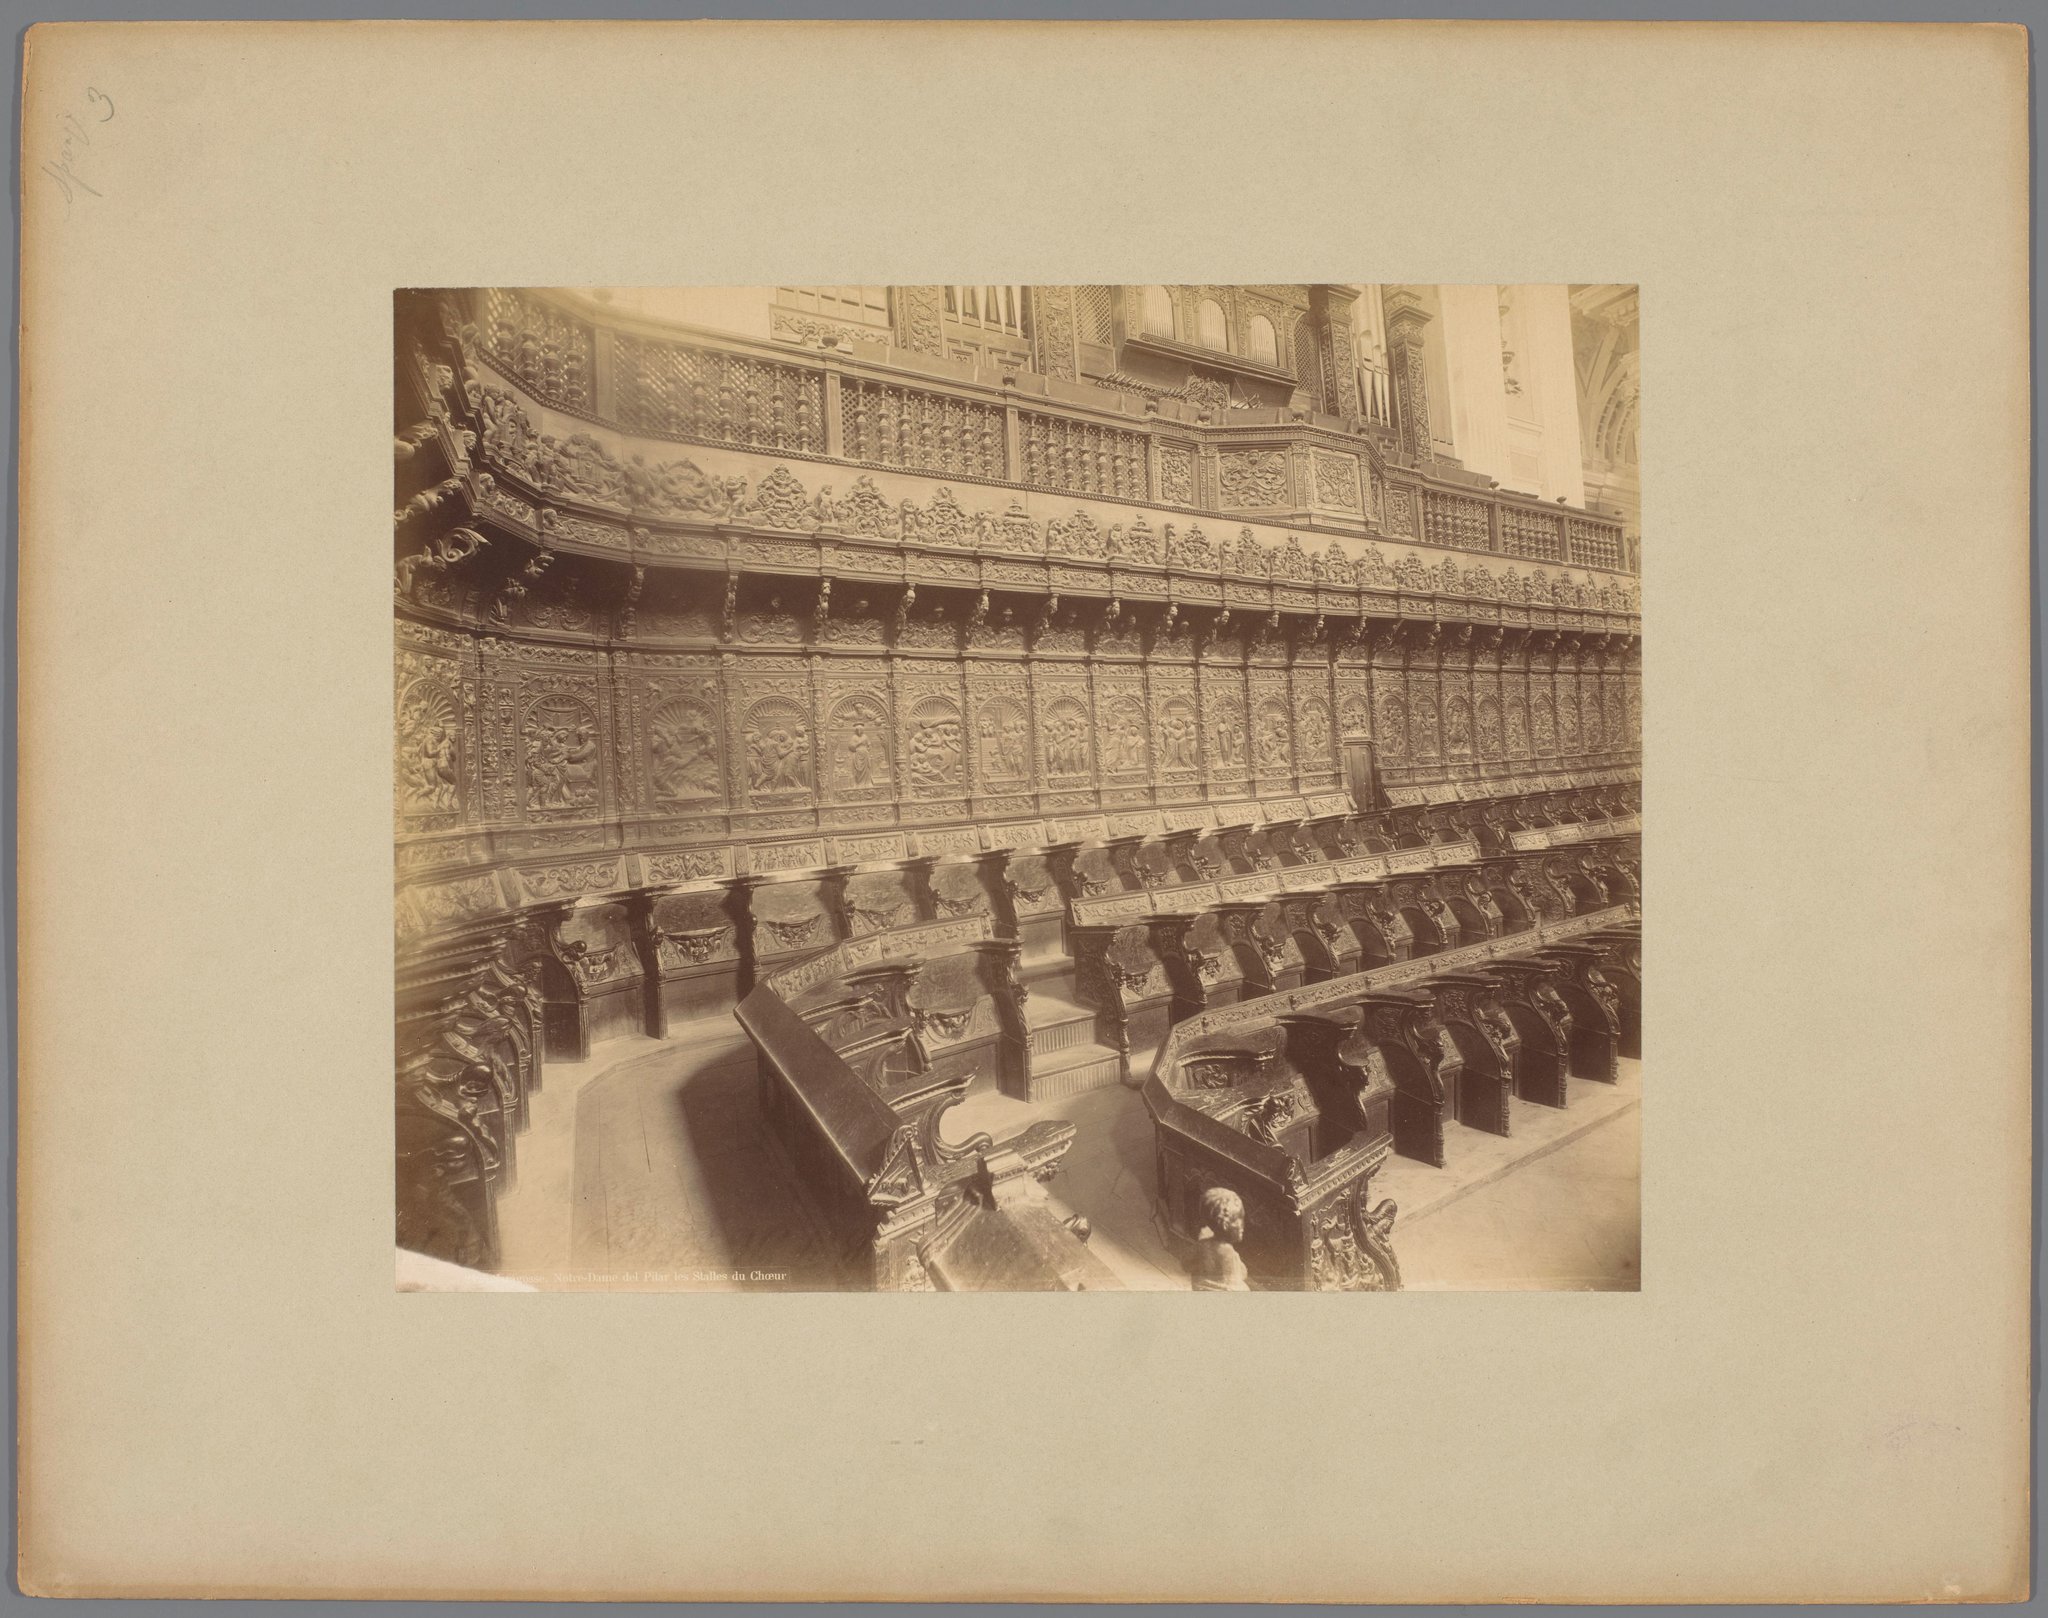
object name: photograph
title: Saragosse. Notre-Dame del Pilar les Stalles du Choeur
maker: Anonymous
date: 1875-1900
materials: cardboard, photographic support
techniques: albumen print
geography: el pilar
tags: interior of church, seats of the clergy, choir-stalls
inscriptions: number: ‘2125’, inscription: ‘T & M B.F.K. Rives No 74’, collector's mark: Lugt 3937